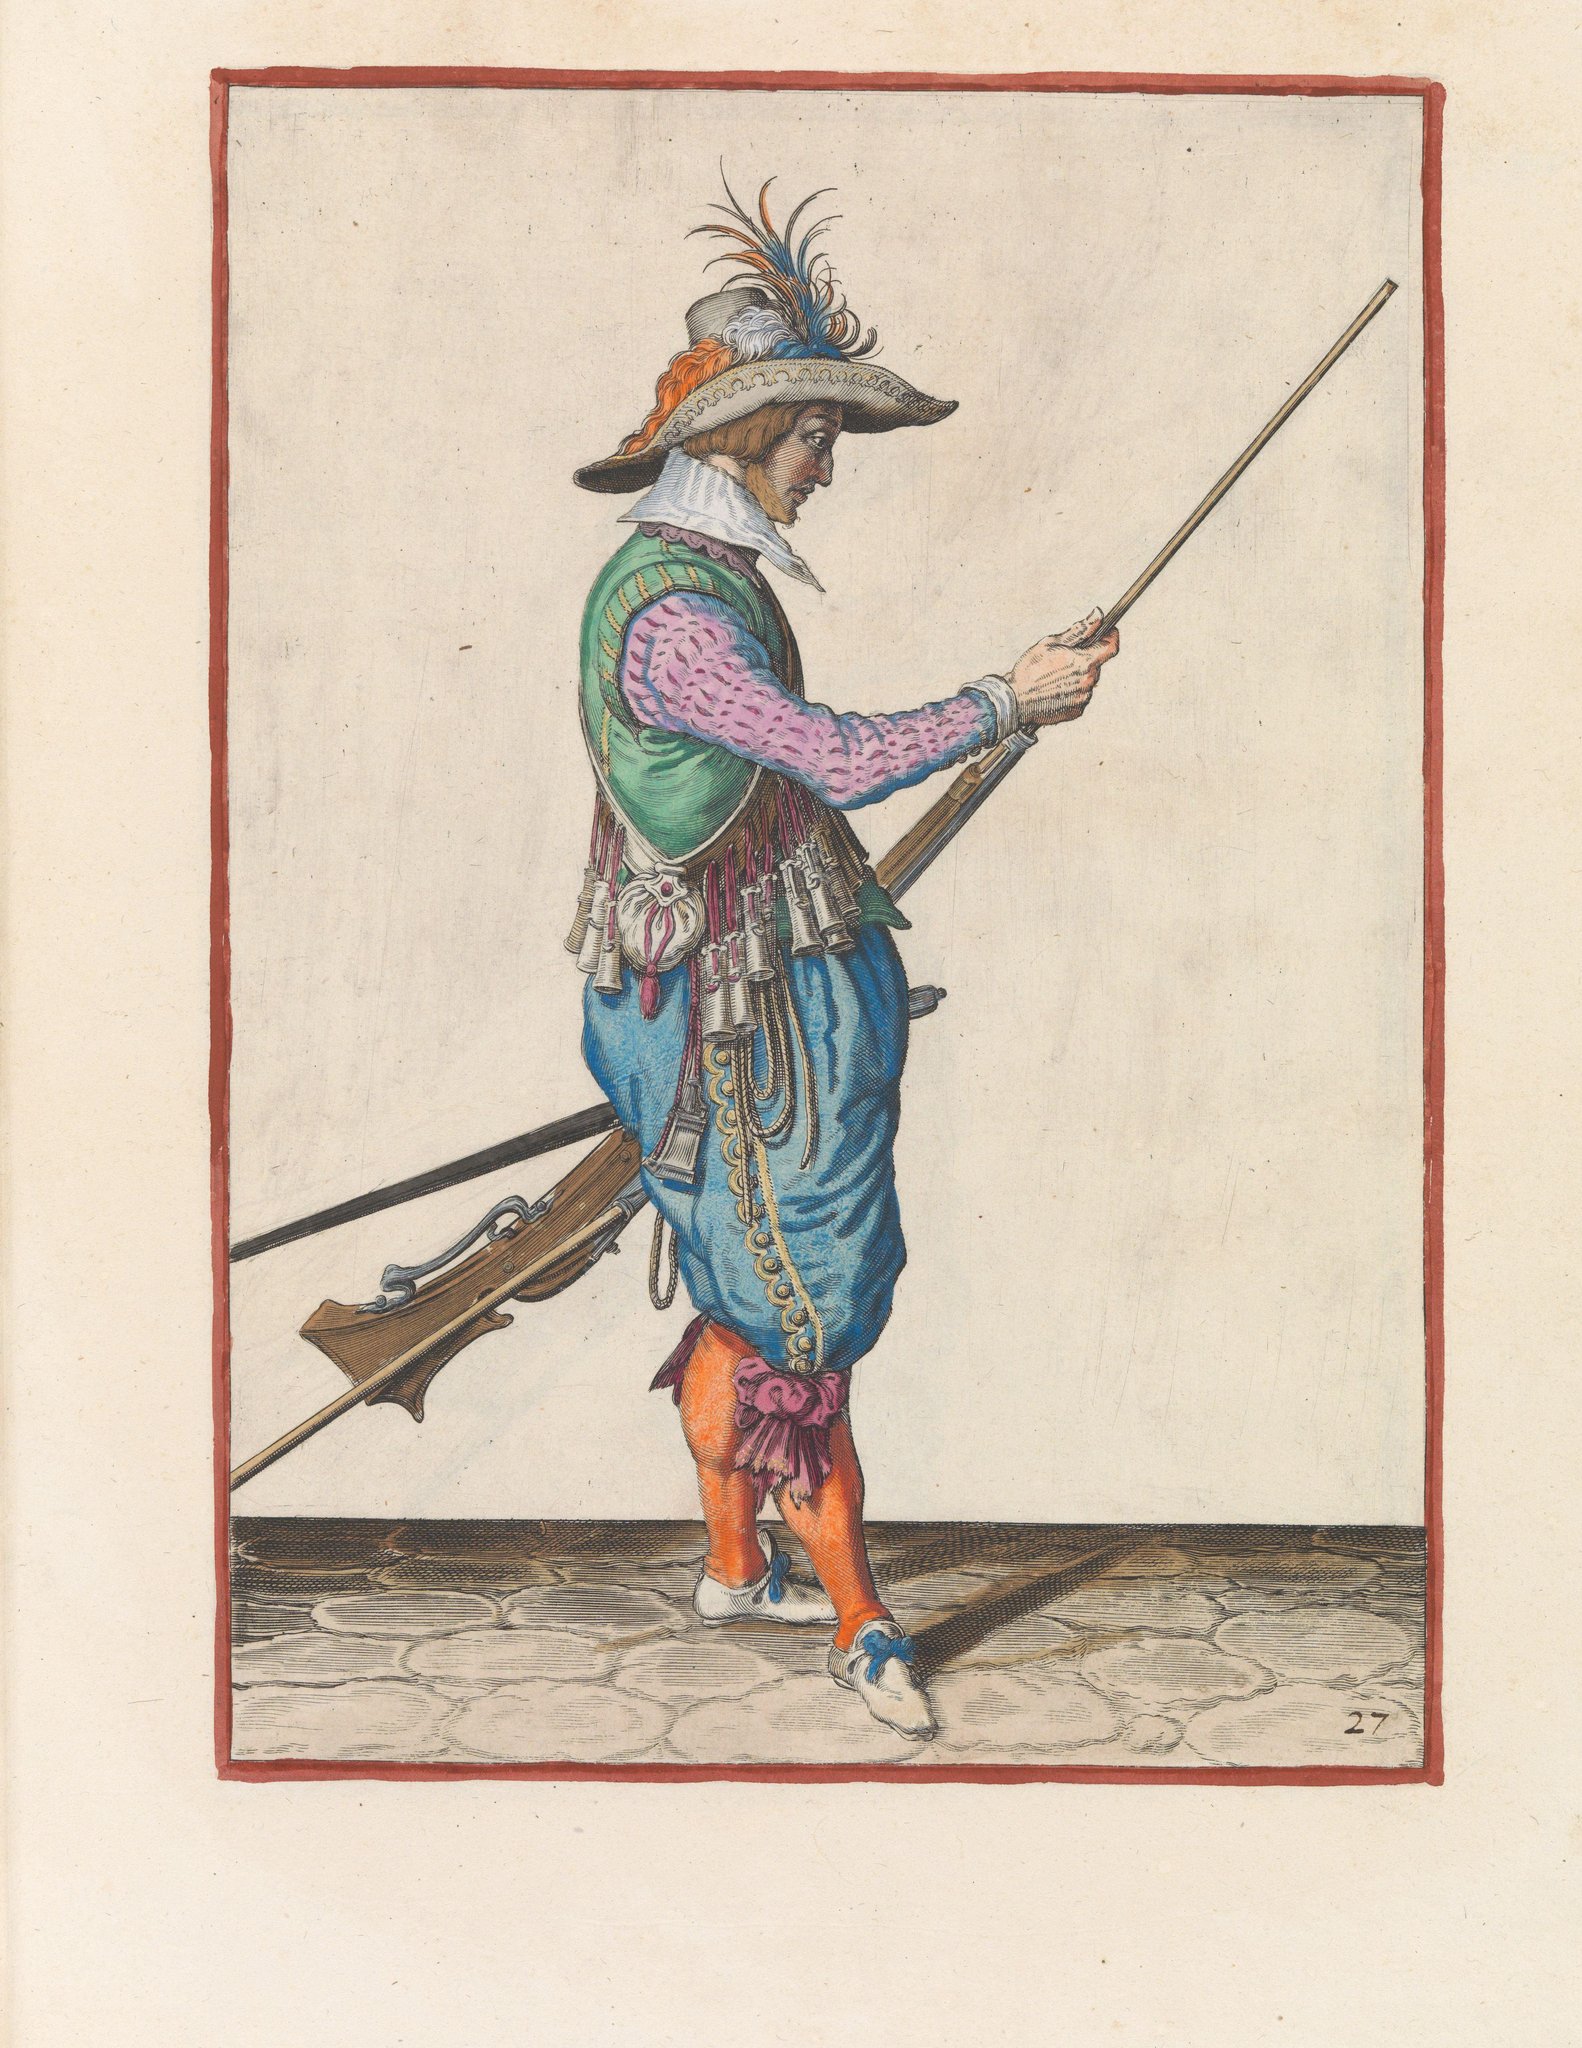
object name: print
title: Soldaat die met zijn laadstok kruit en kogel in de loop van zijn musket duwt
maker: jacques de gheyn (ii)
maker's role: painter, print maker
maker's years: 1565-1629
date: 1597-1607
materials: paper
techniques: engraving, hand coloring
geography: the hague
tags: handling of weapons ~ military training, firearms: rifle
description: Een soldaat, ten voeten uit, naar rechts, die met zijn linkerhand bij zijn linkerdijbeen een musket (een bepaald type vuurwapen) vasthoudt en met zijn rechterhand zijn laadstok in de loop brengt, om kruit en kogel aan te duwen. In zijn linkerhand behalve het musket ook een furket (musketvork) en een lont. Deze prent is onderdeel van de reeks van 43 met de hand genummerde prenten van musketiers in de Wapenhandelinghe.